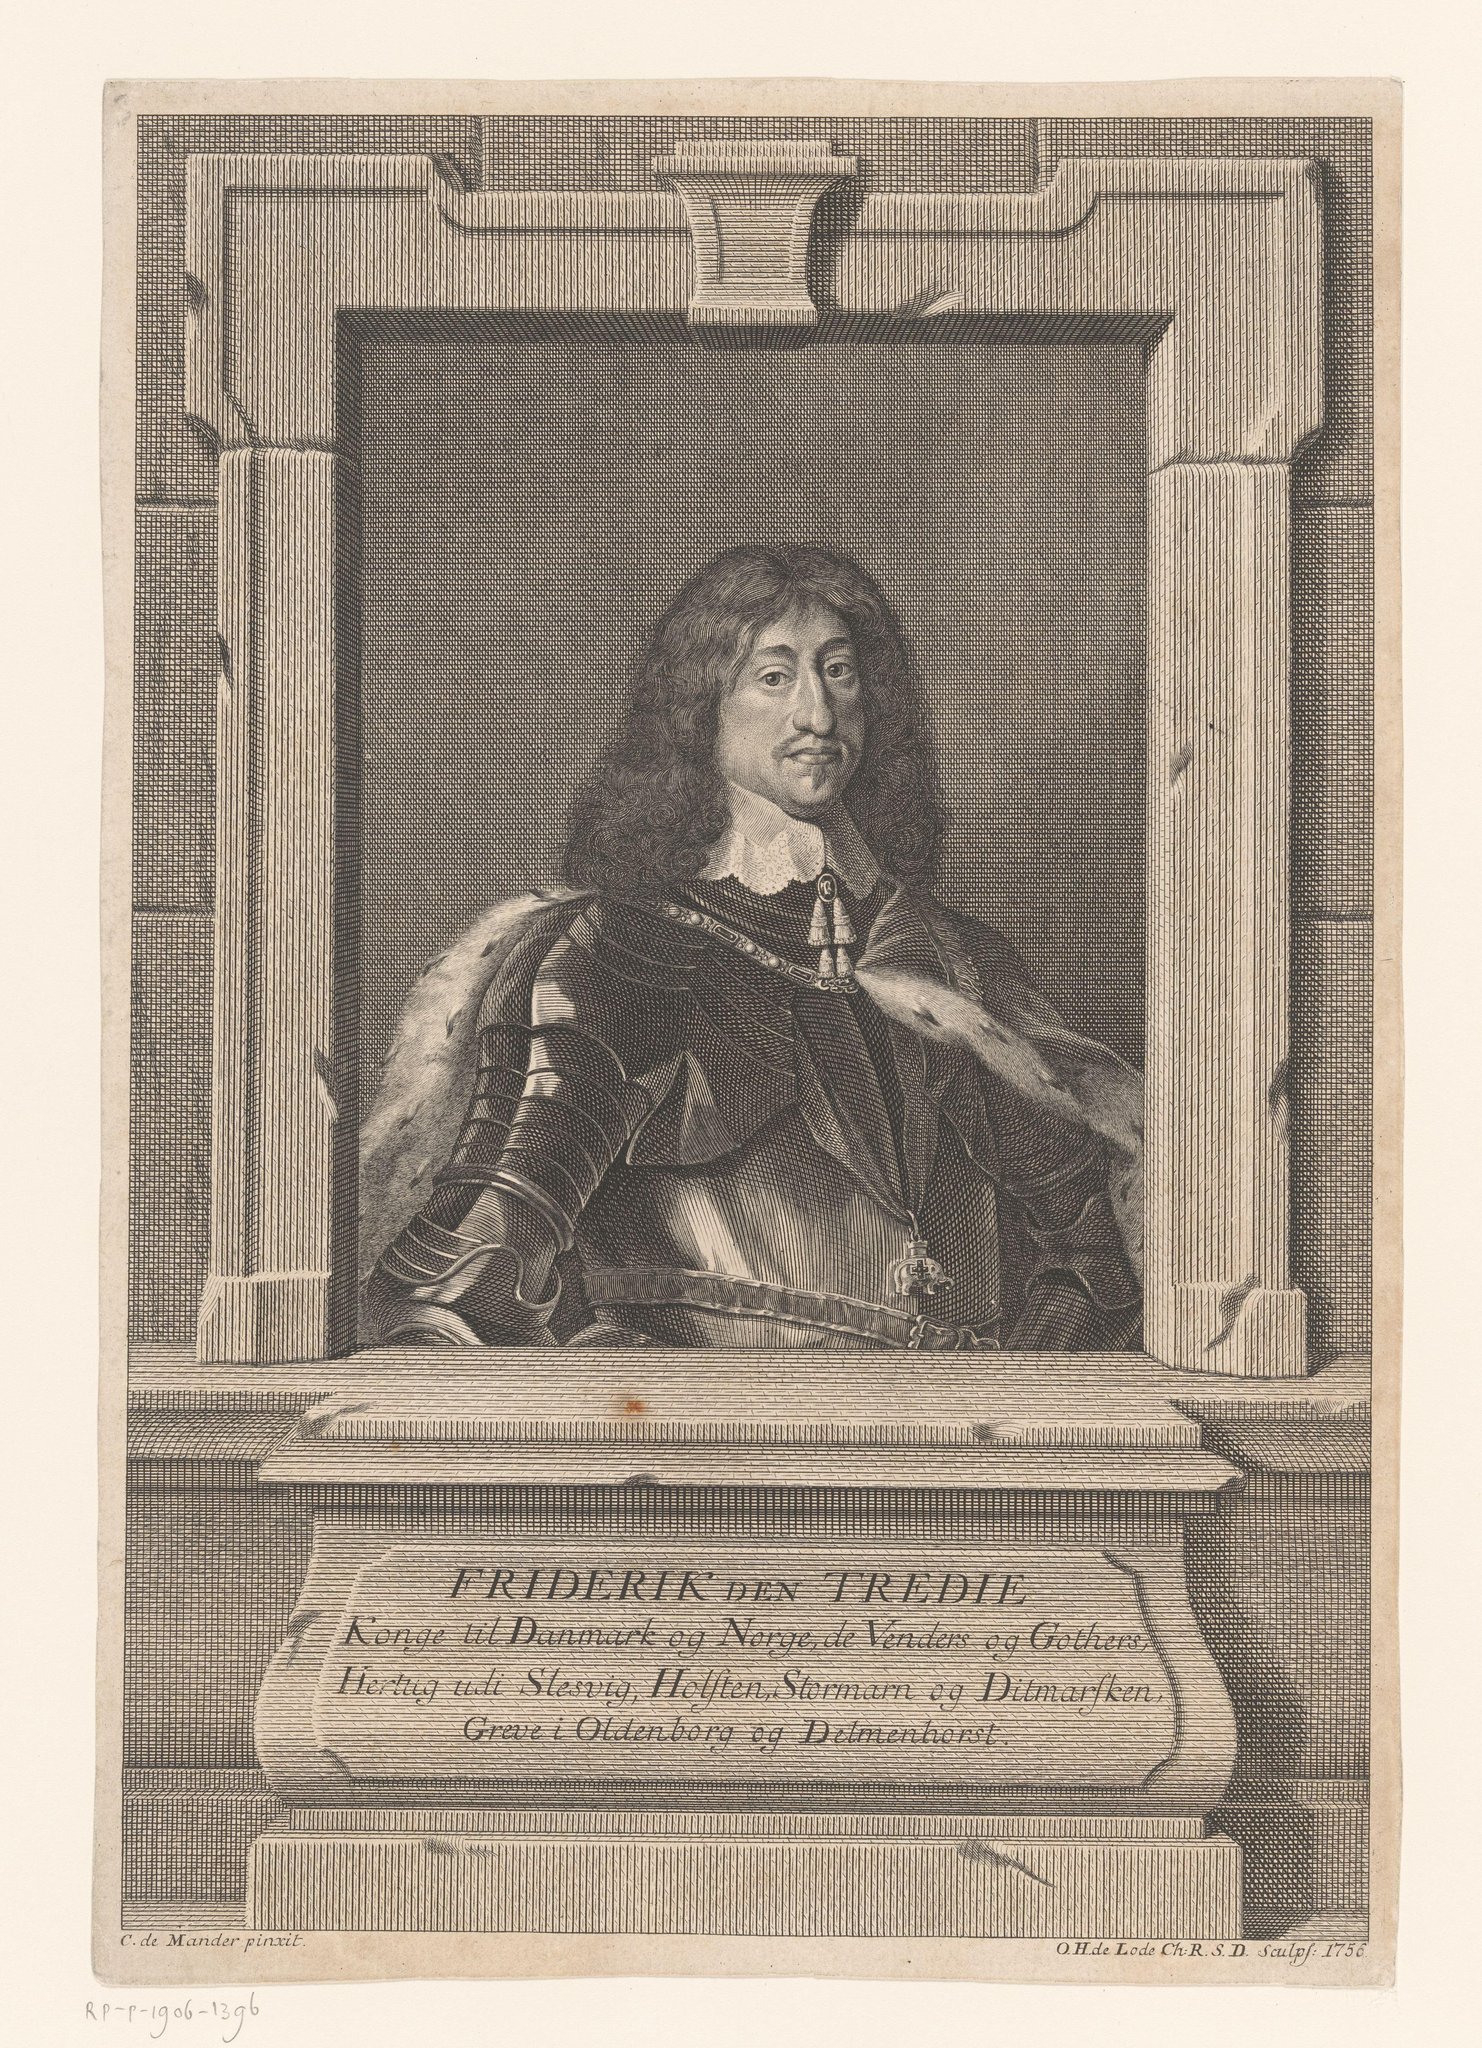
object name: print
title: Frederik III van Denemarken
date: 1756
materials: paper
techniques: engraving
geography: denmark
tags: copenhagen (city), frederik iii (koning van denemarken en noorwegen), historical persons, king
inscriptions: collector's mark: Lugt 2228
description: Portret van koning Frederik III van Denemarken (1609-1670). Naar het schilderij van Karel van Mander III uit 1656.